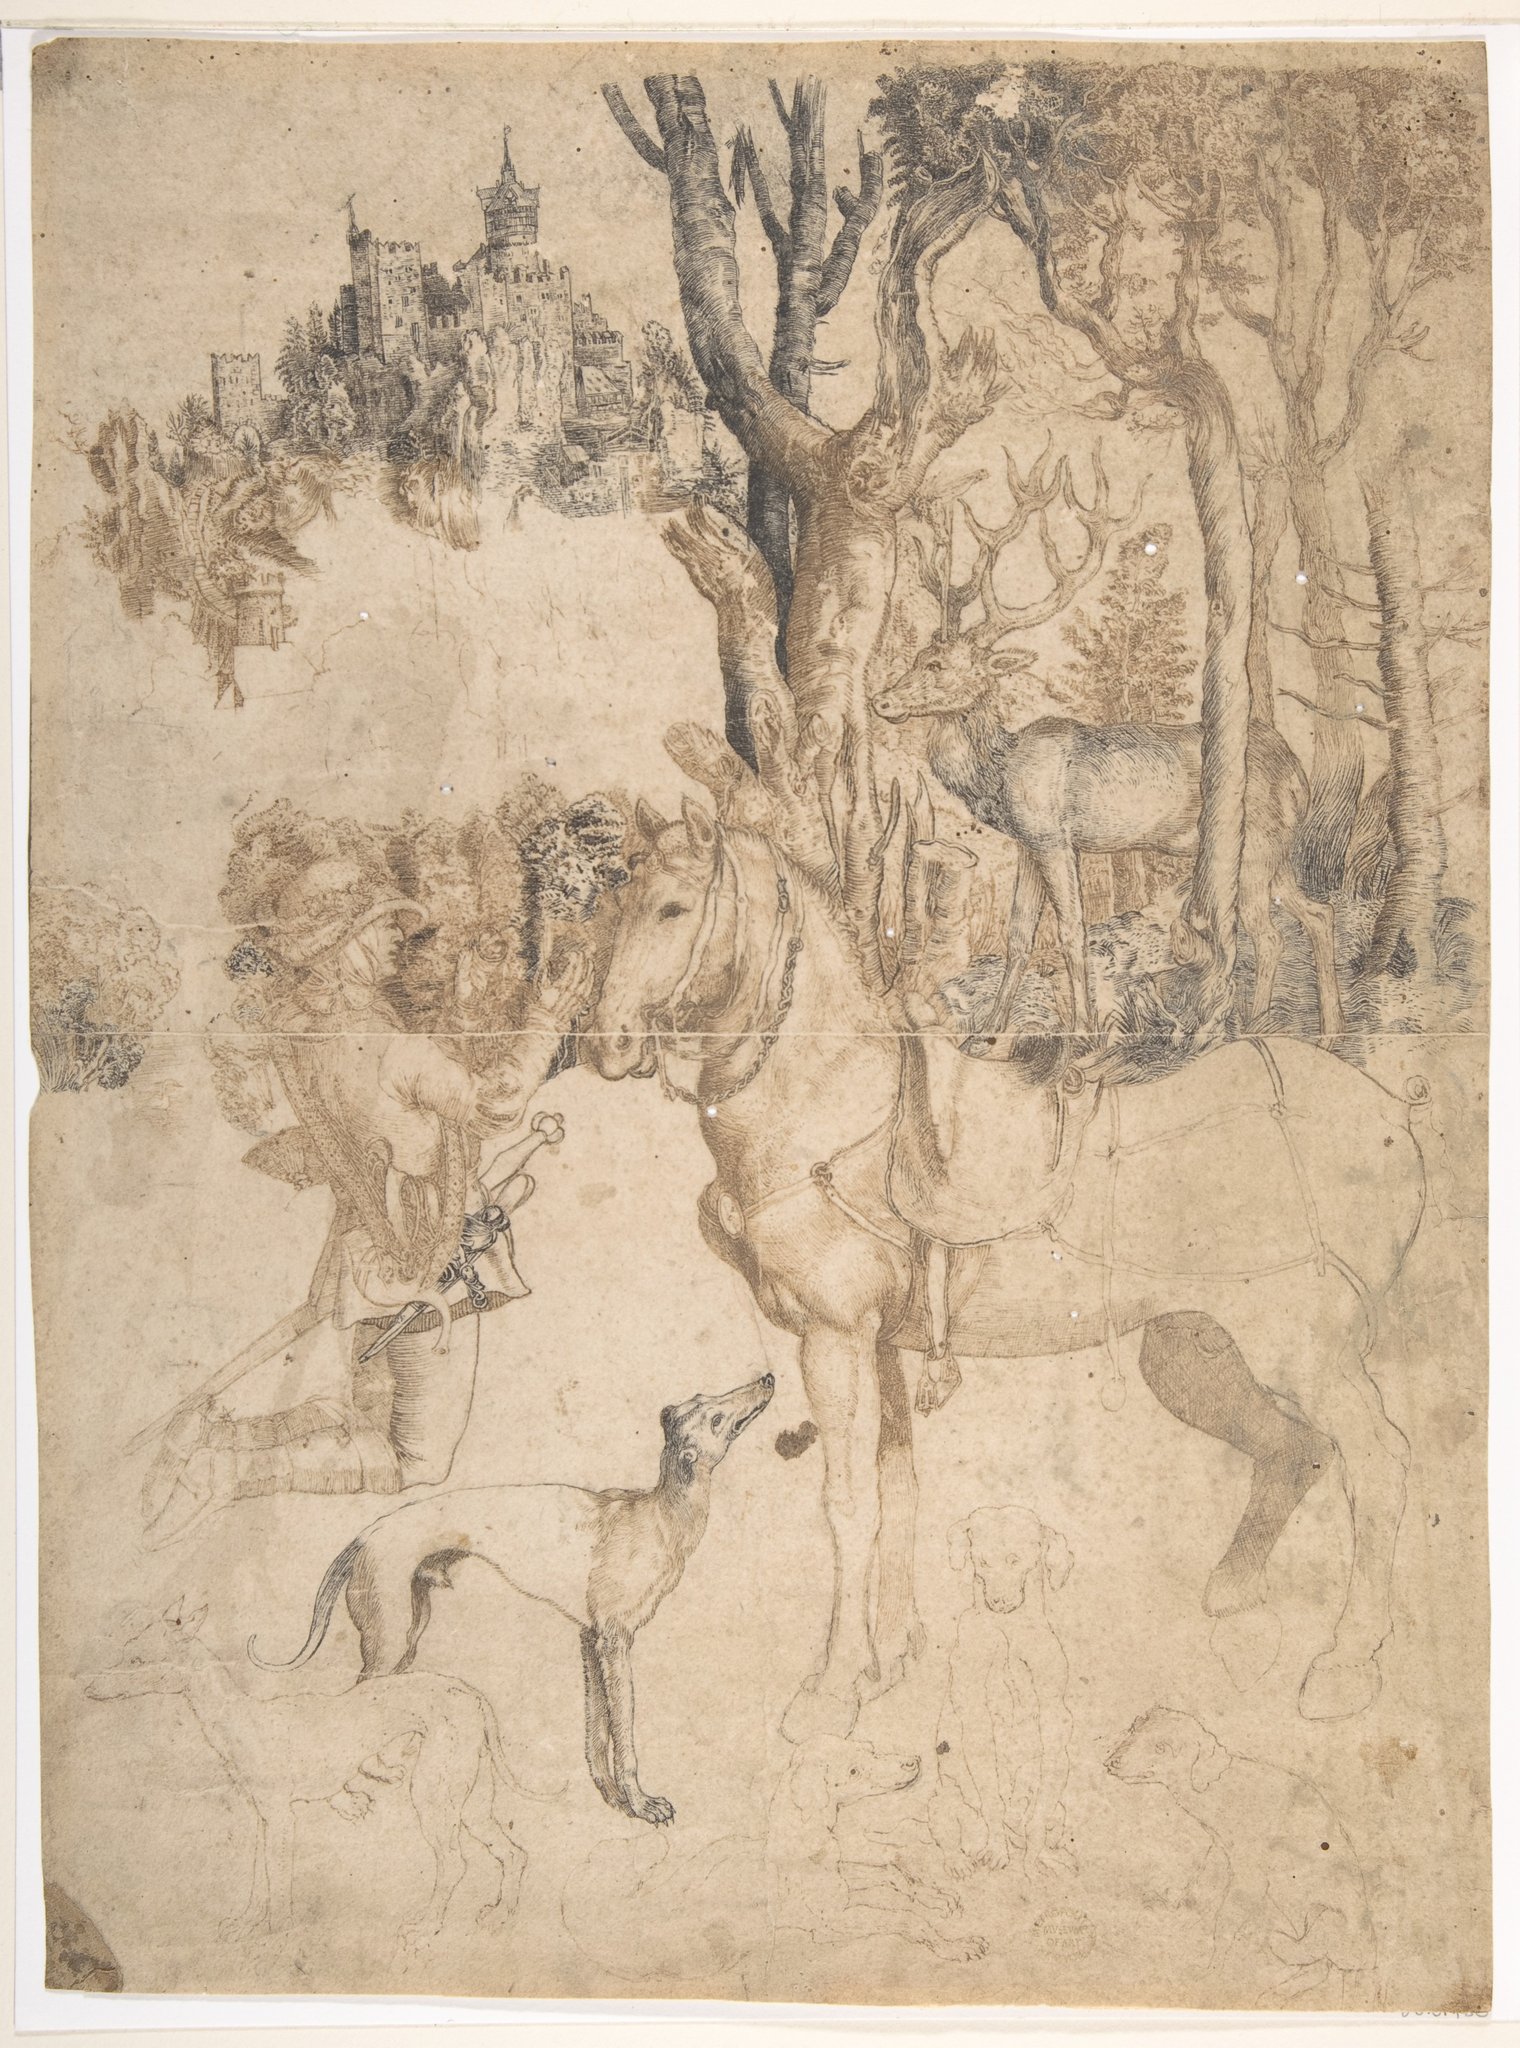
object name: drawing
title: The Vision of Saint Eustace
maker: anonymous, german, 16th century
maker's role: artist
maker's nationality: german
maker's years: 1500-1600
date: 1501-1600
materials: chalk, ink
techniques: pen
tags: men,deer,dogs,horses